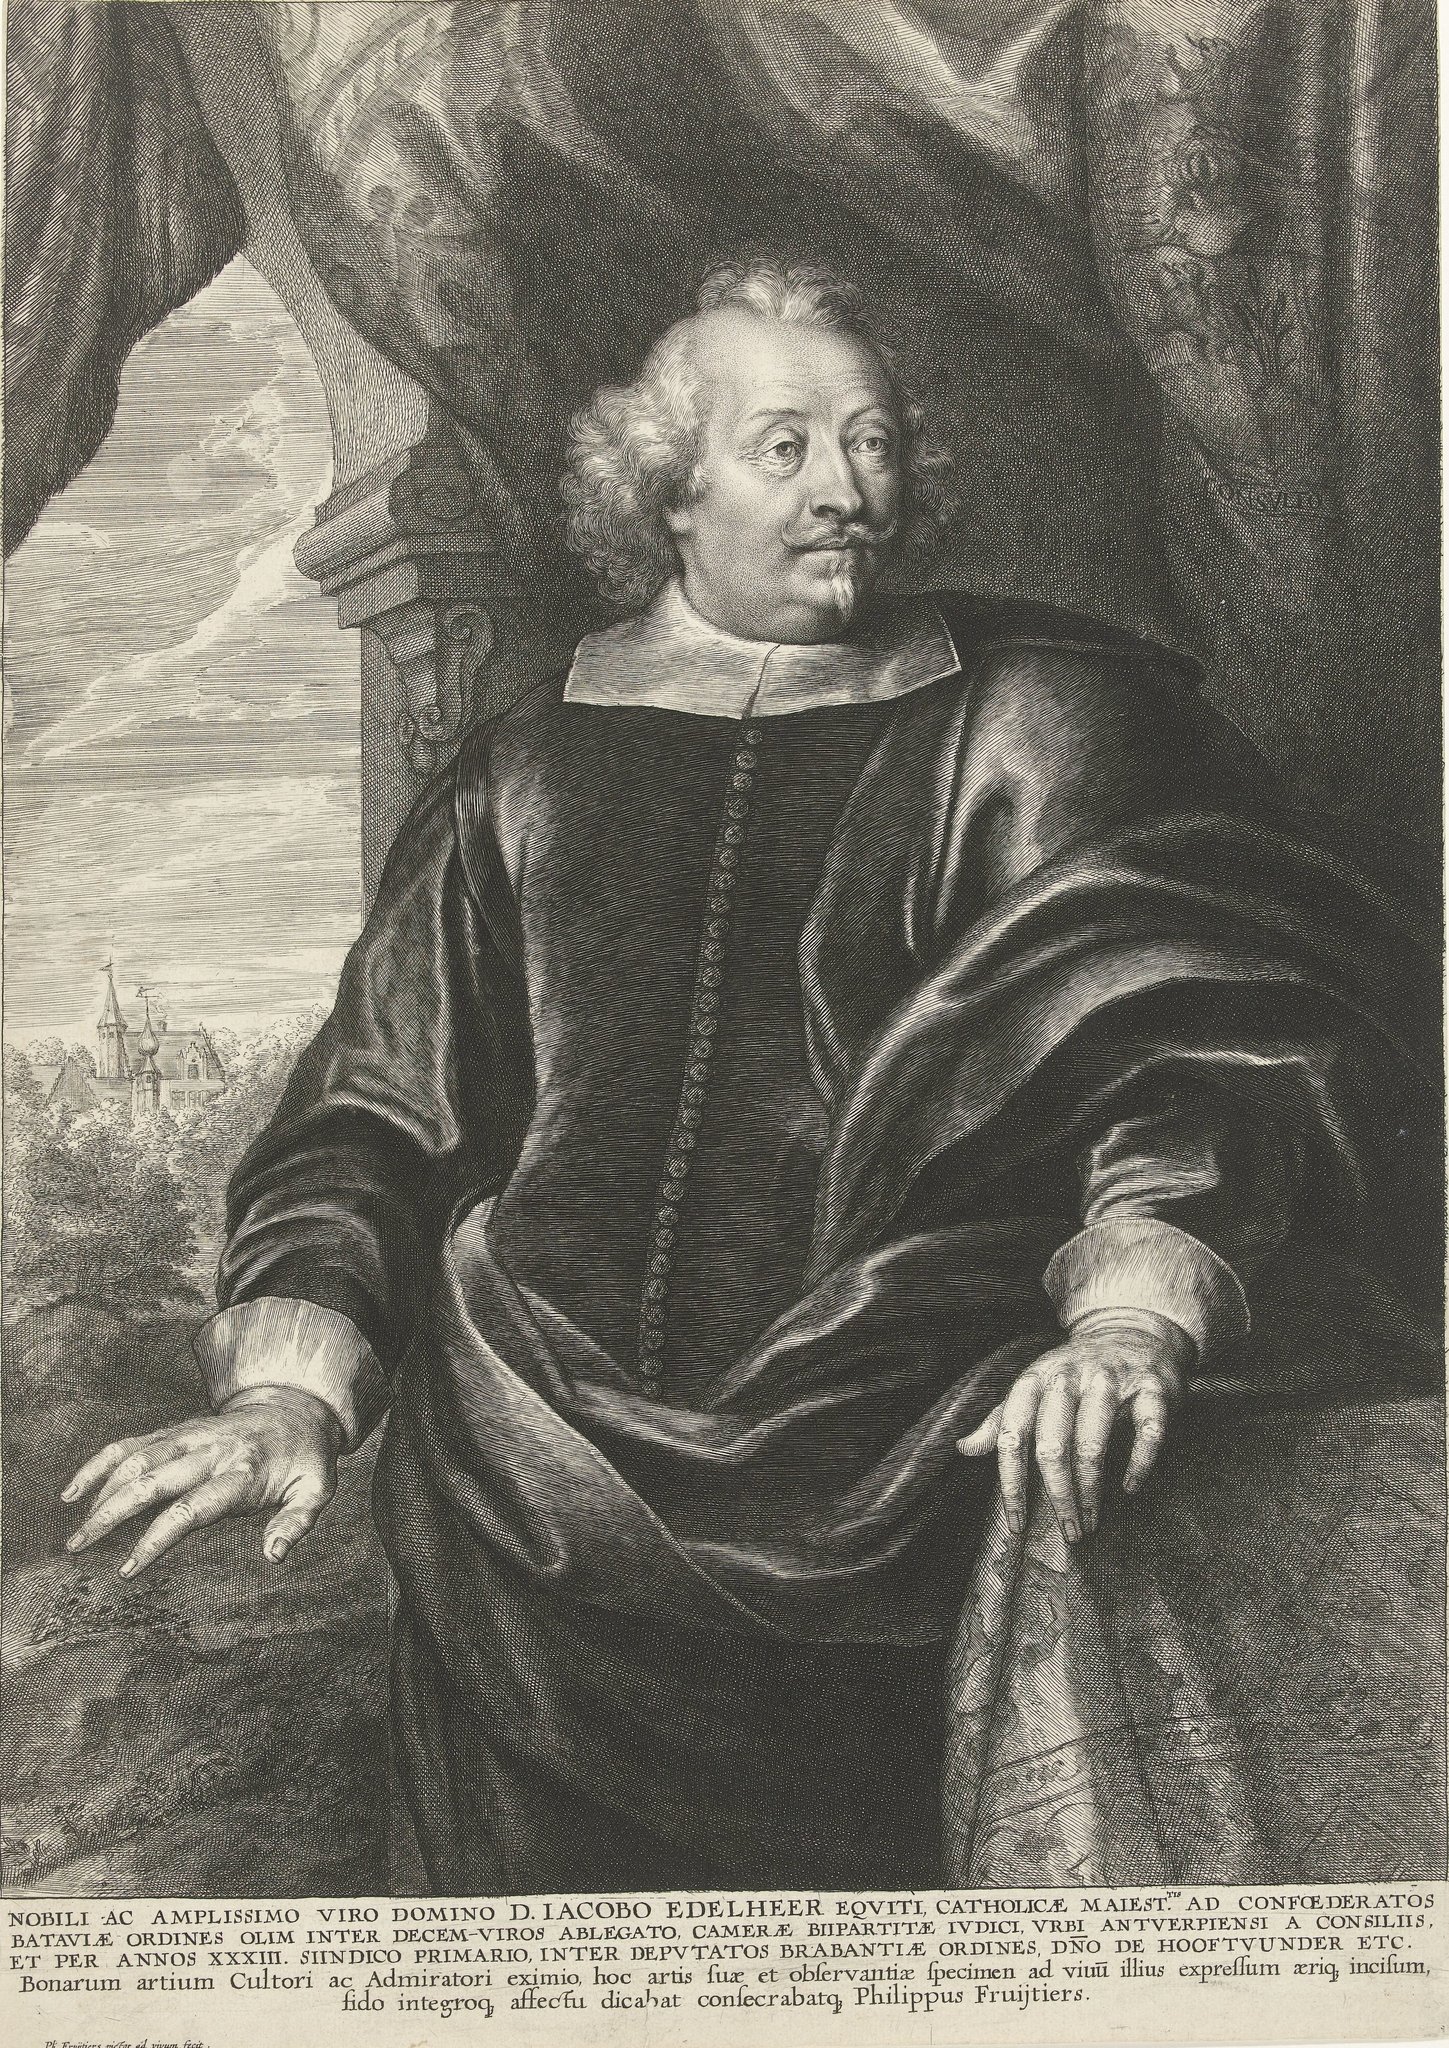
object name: print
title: Portret van Jacobus Edelheer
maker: philip fruytiers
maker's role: print maker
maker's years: 1610-1666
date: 1620-1666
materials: paper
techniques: etching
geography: antwerp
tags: louvain, antwerp, politician, jacobus edelheer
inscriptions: inscription: ‘F. Reichberger 1801’, collector's mark: Lugt 12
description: De jurist en schrijver Jacobus Edelheer, staand naast een tafel, voor een draperie. In de marge een vijfregelige tekst in het Latijn.